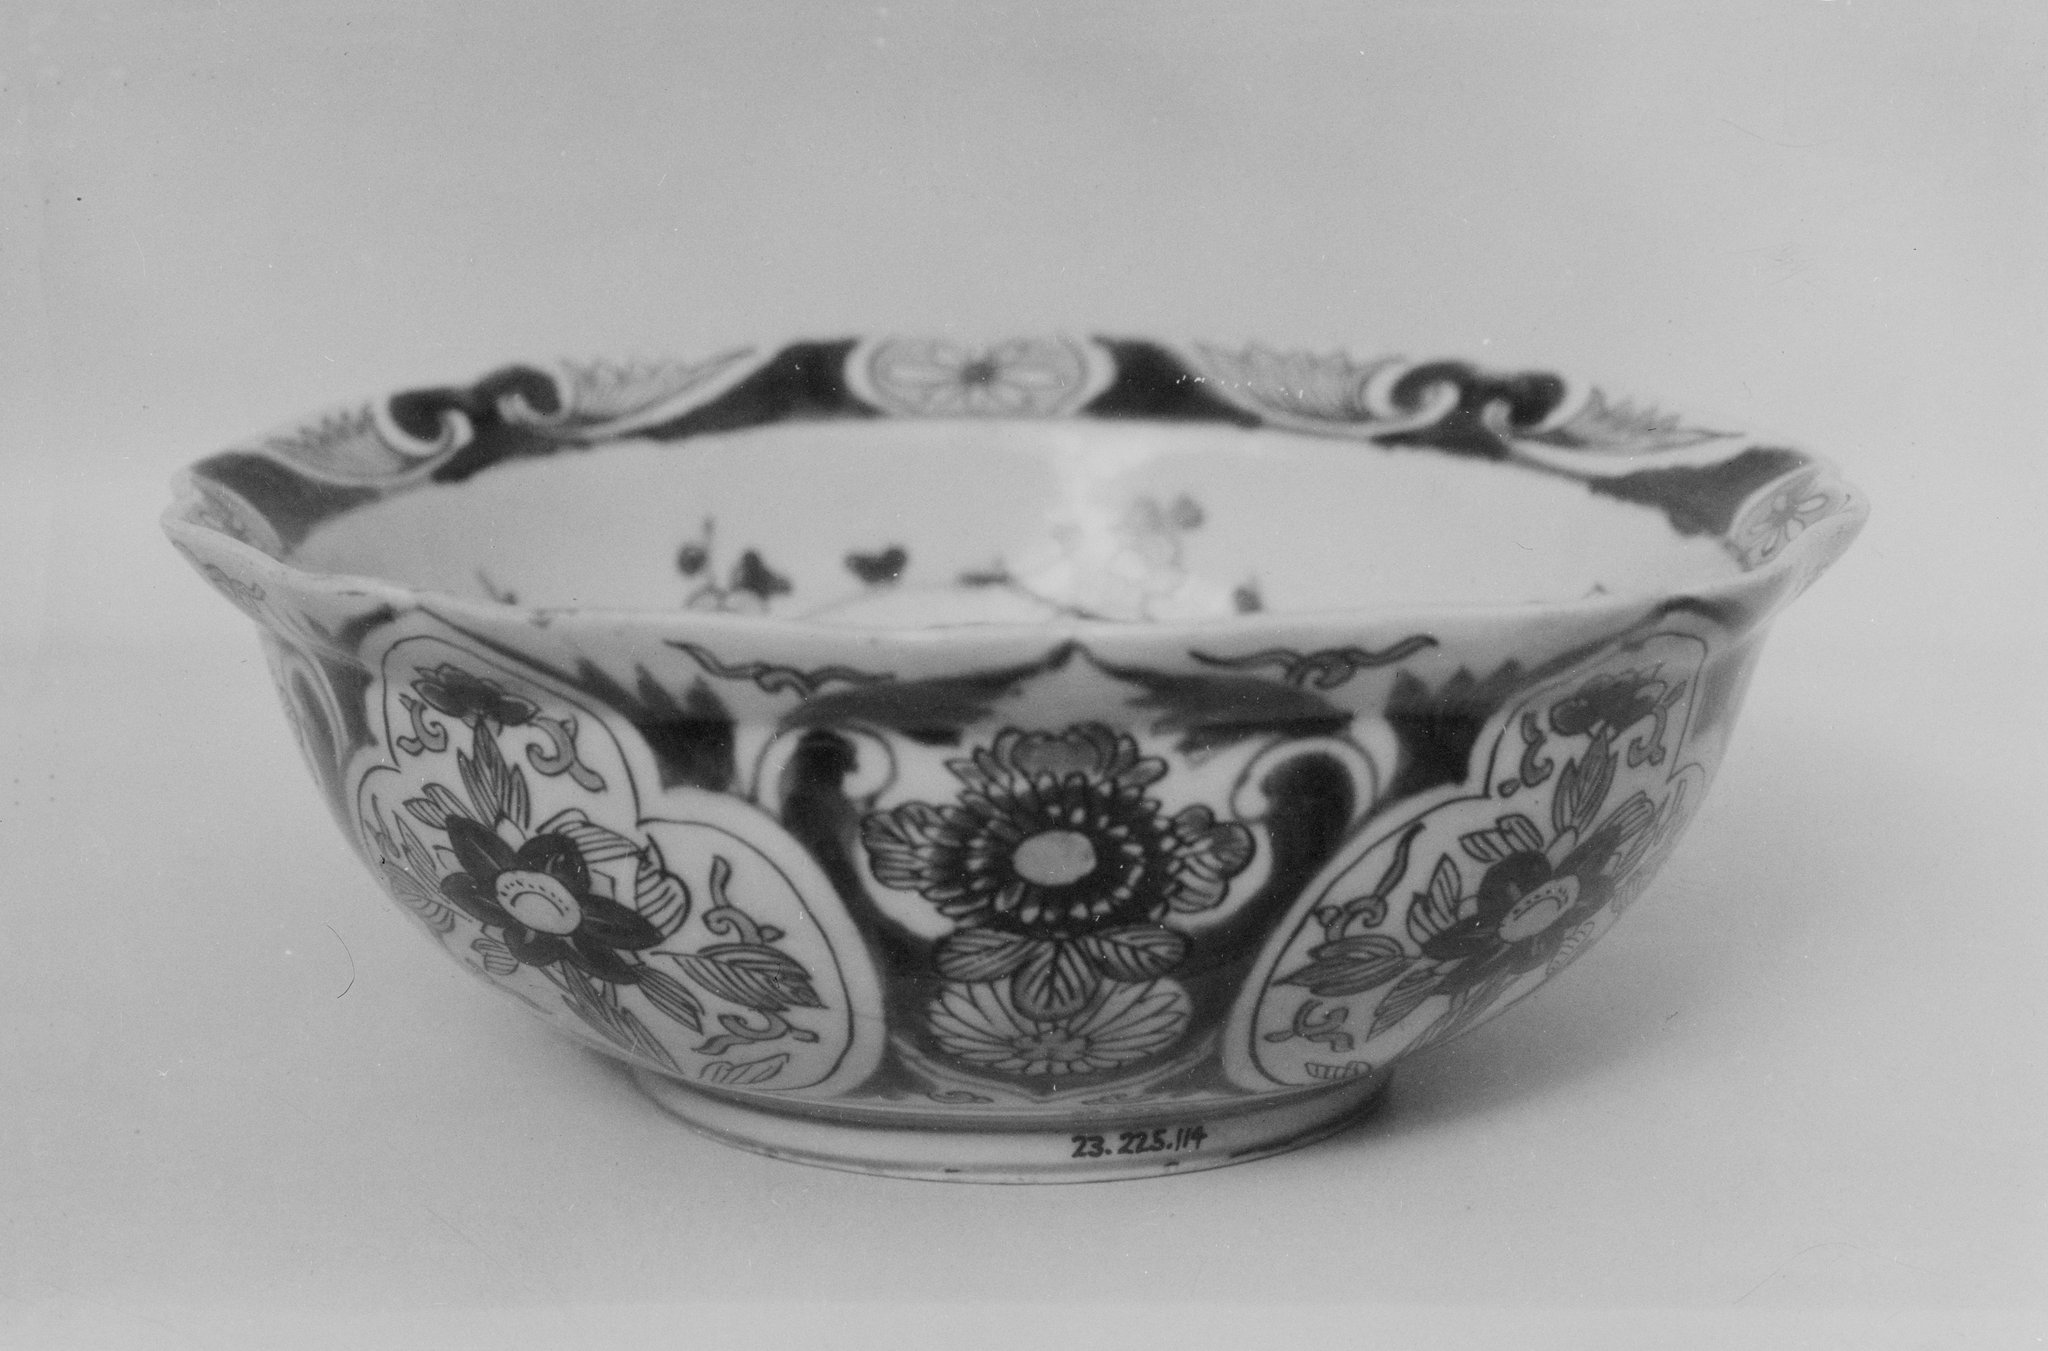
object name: bowl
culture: japanese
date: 1680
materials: enamel, porcelain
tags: flowers